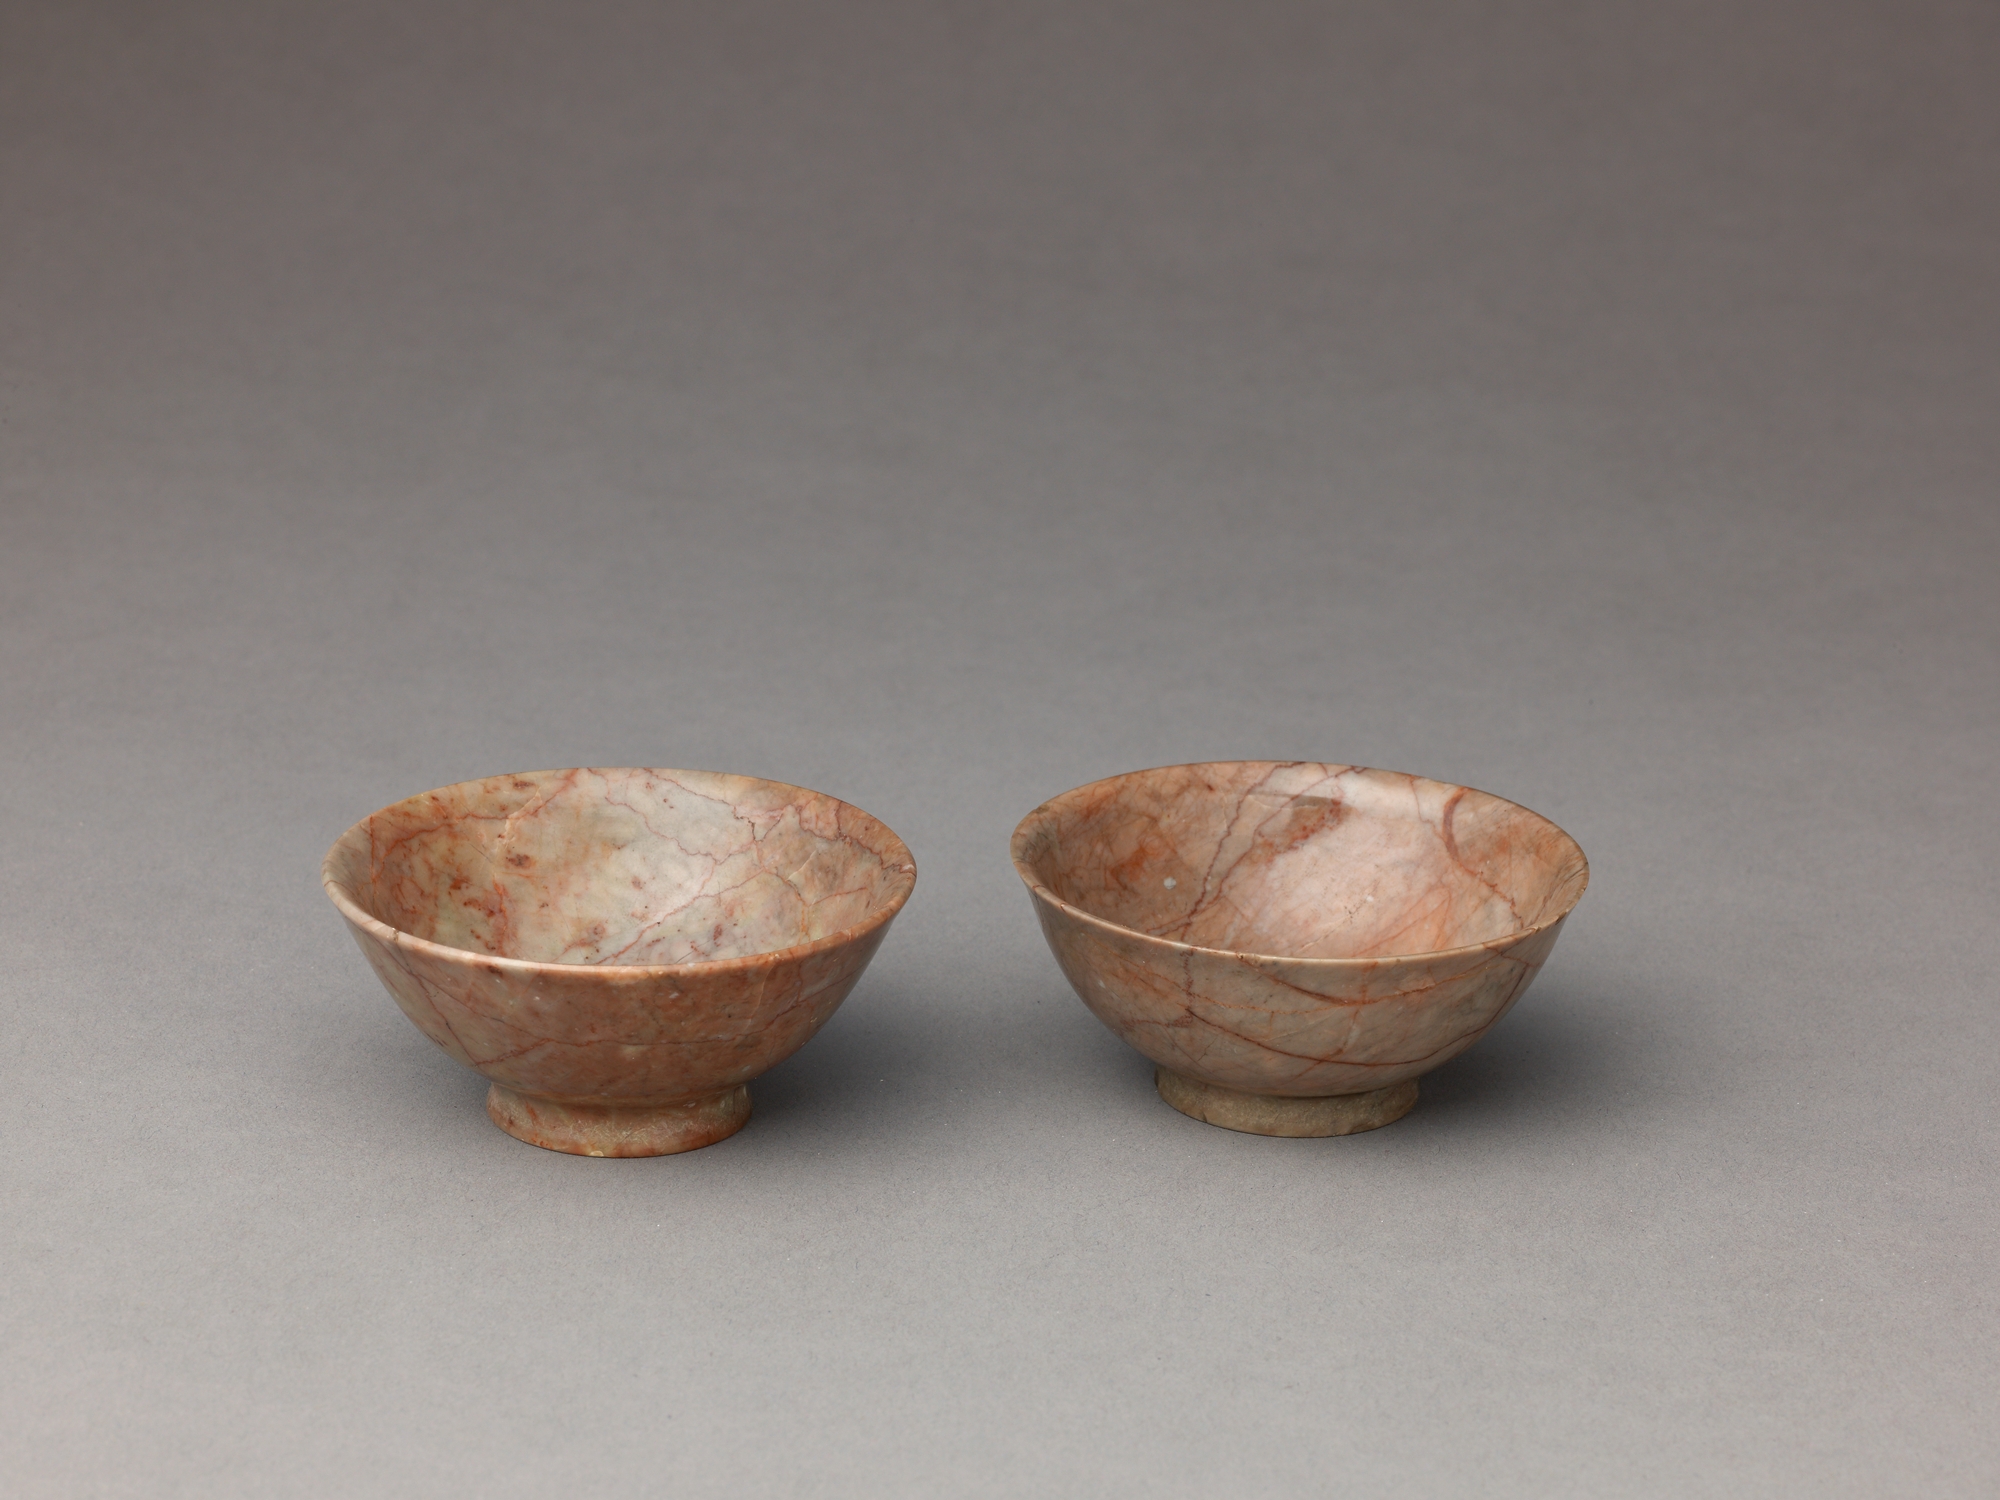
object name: bowl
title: Bowl (see also 1975.1.1750)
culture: chinese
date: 1801-1900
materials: limestone